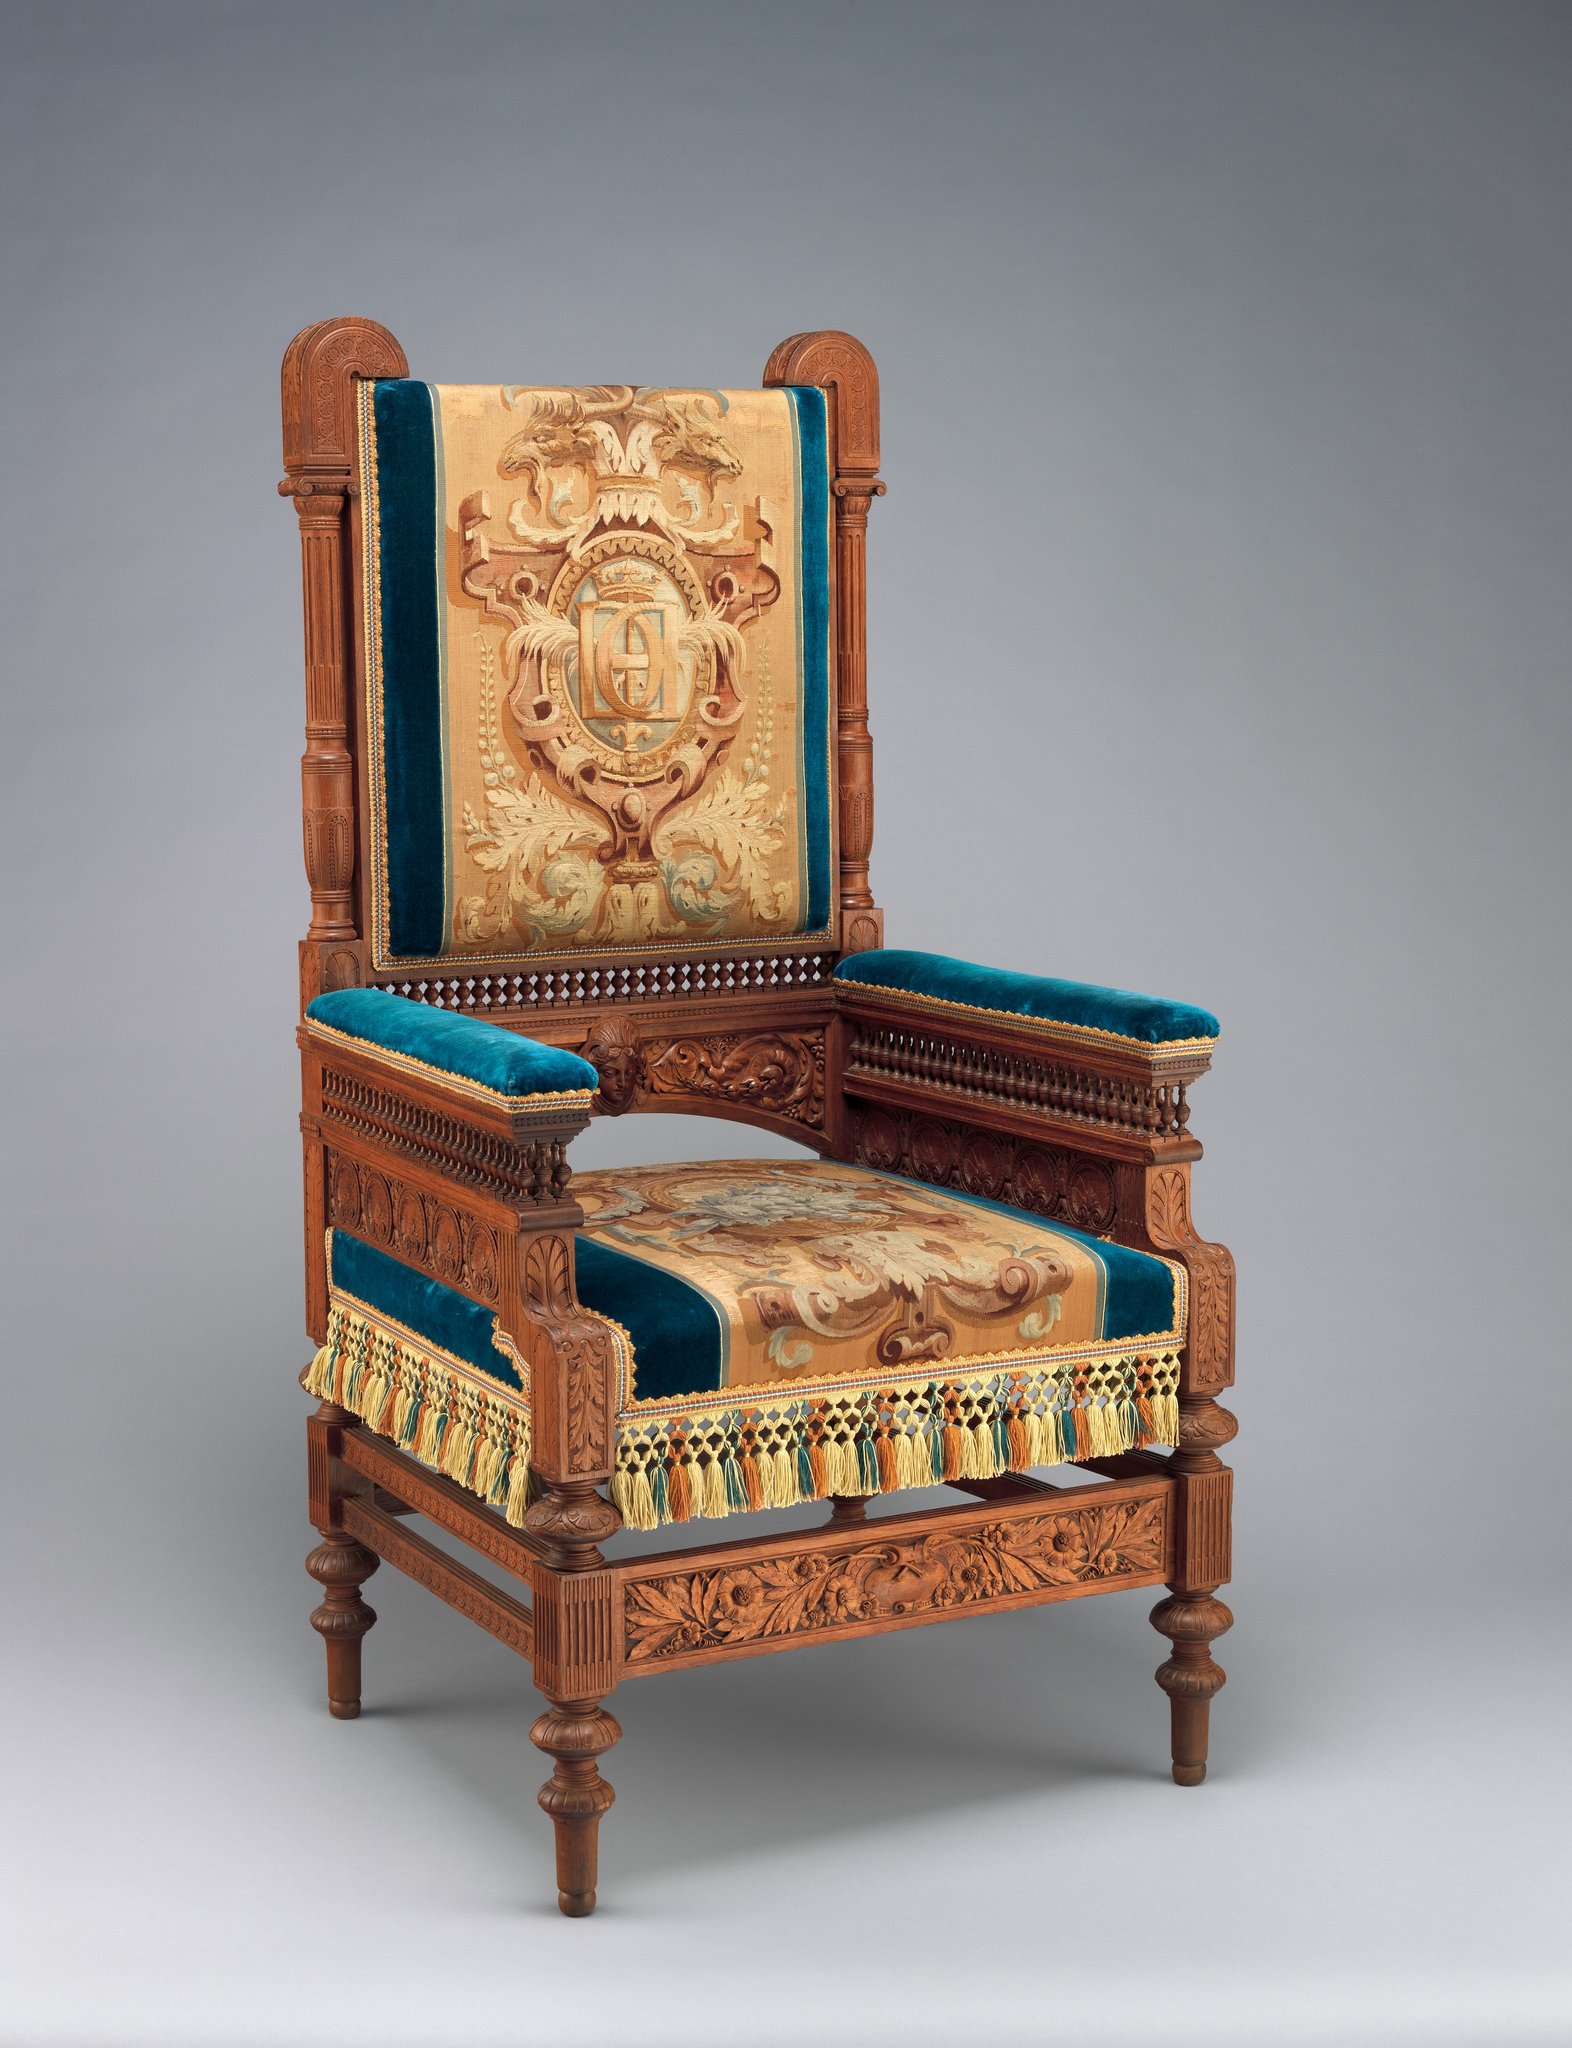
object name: armchair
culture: american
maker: pottier and stymus manufacturing company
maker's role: maker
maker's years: 1858-1919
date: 1875-1876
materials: wood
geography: united states